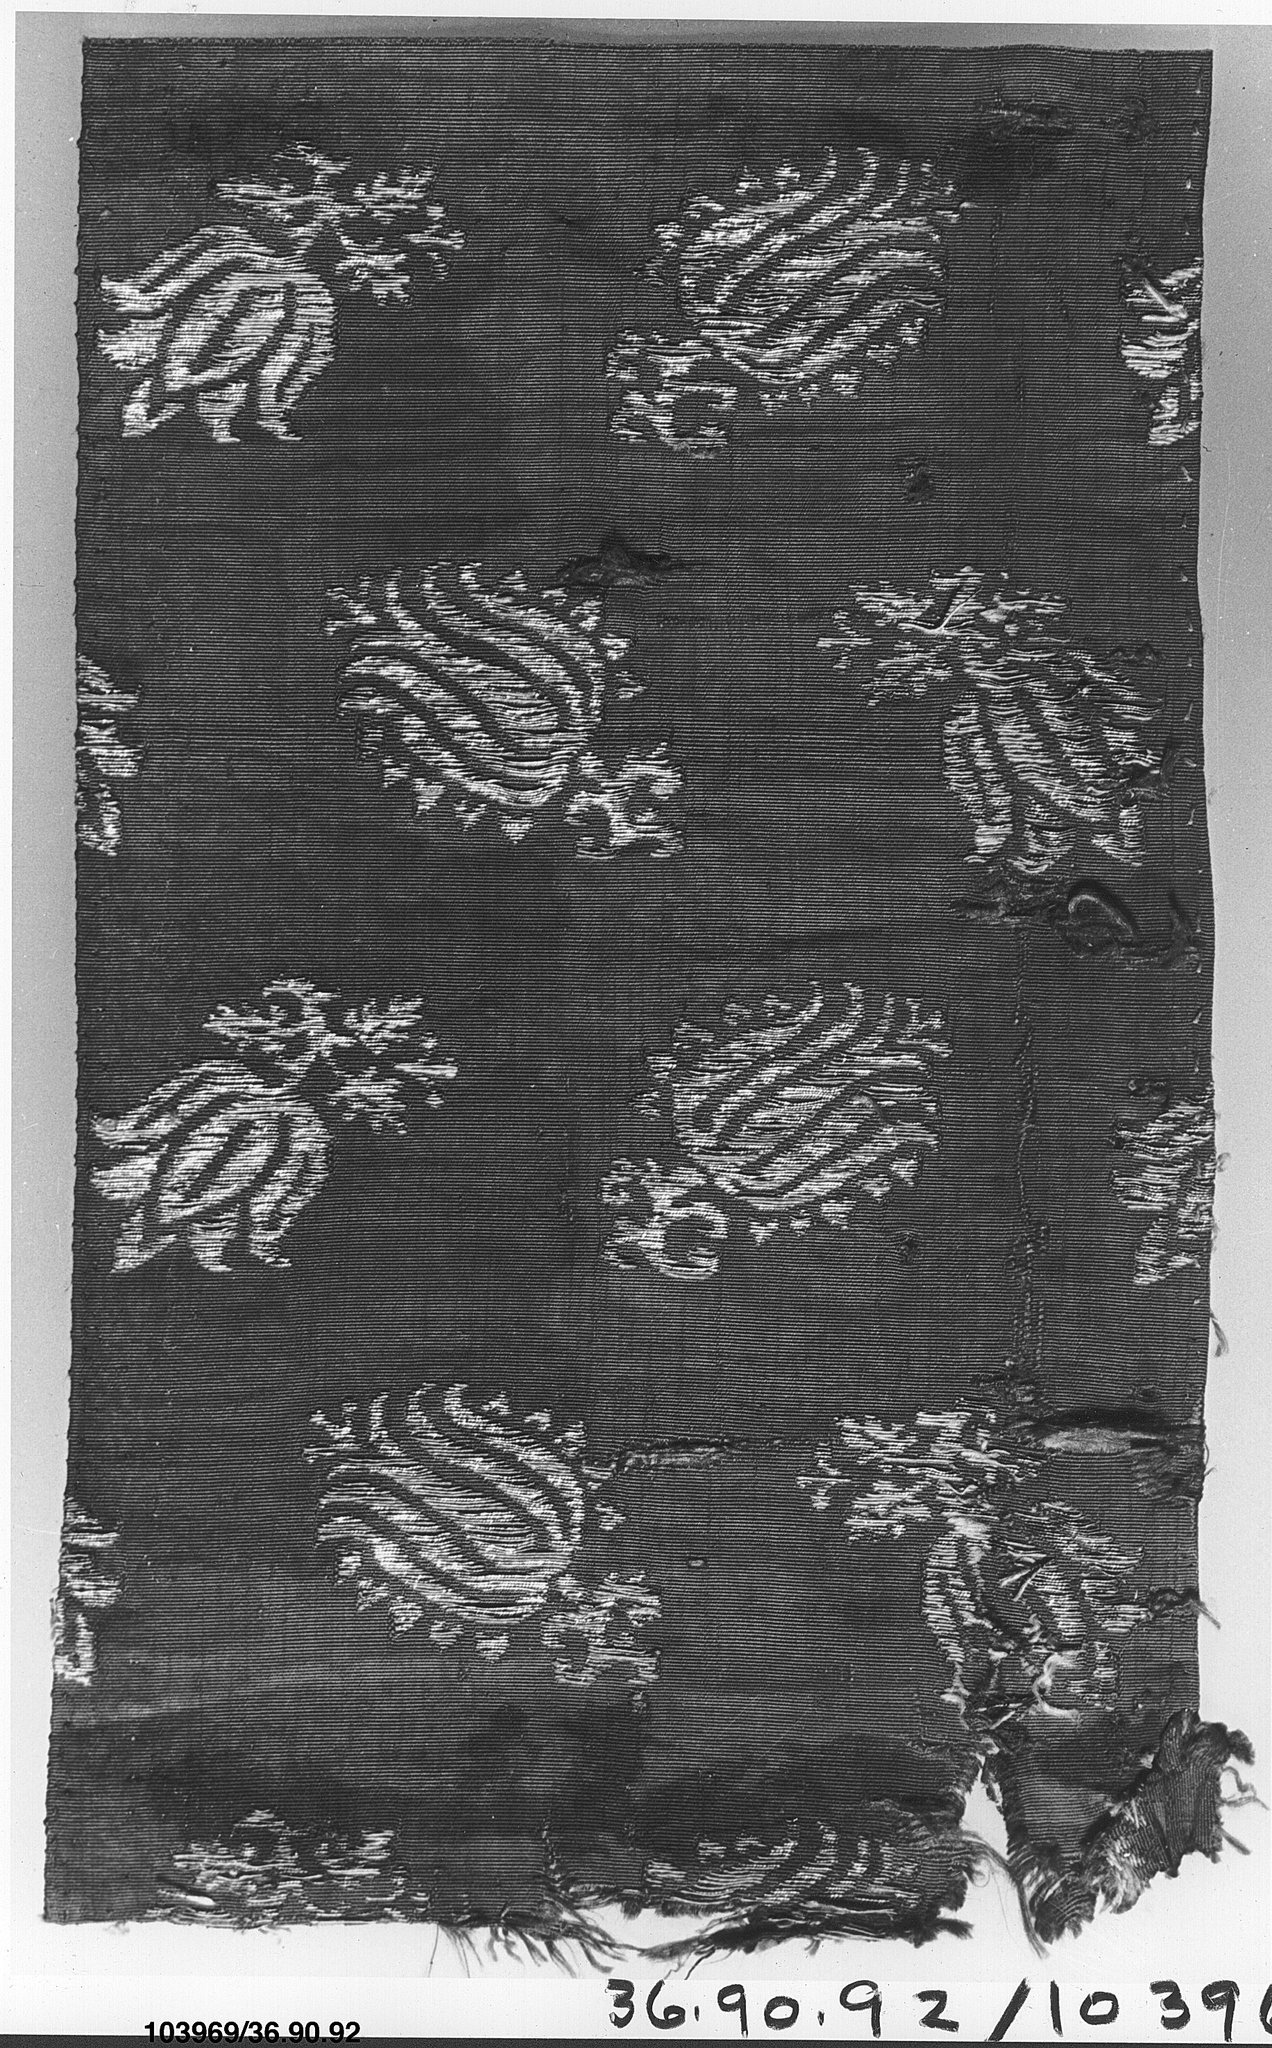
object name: piece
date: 1501-1700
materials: metal thread, silk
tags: flowers